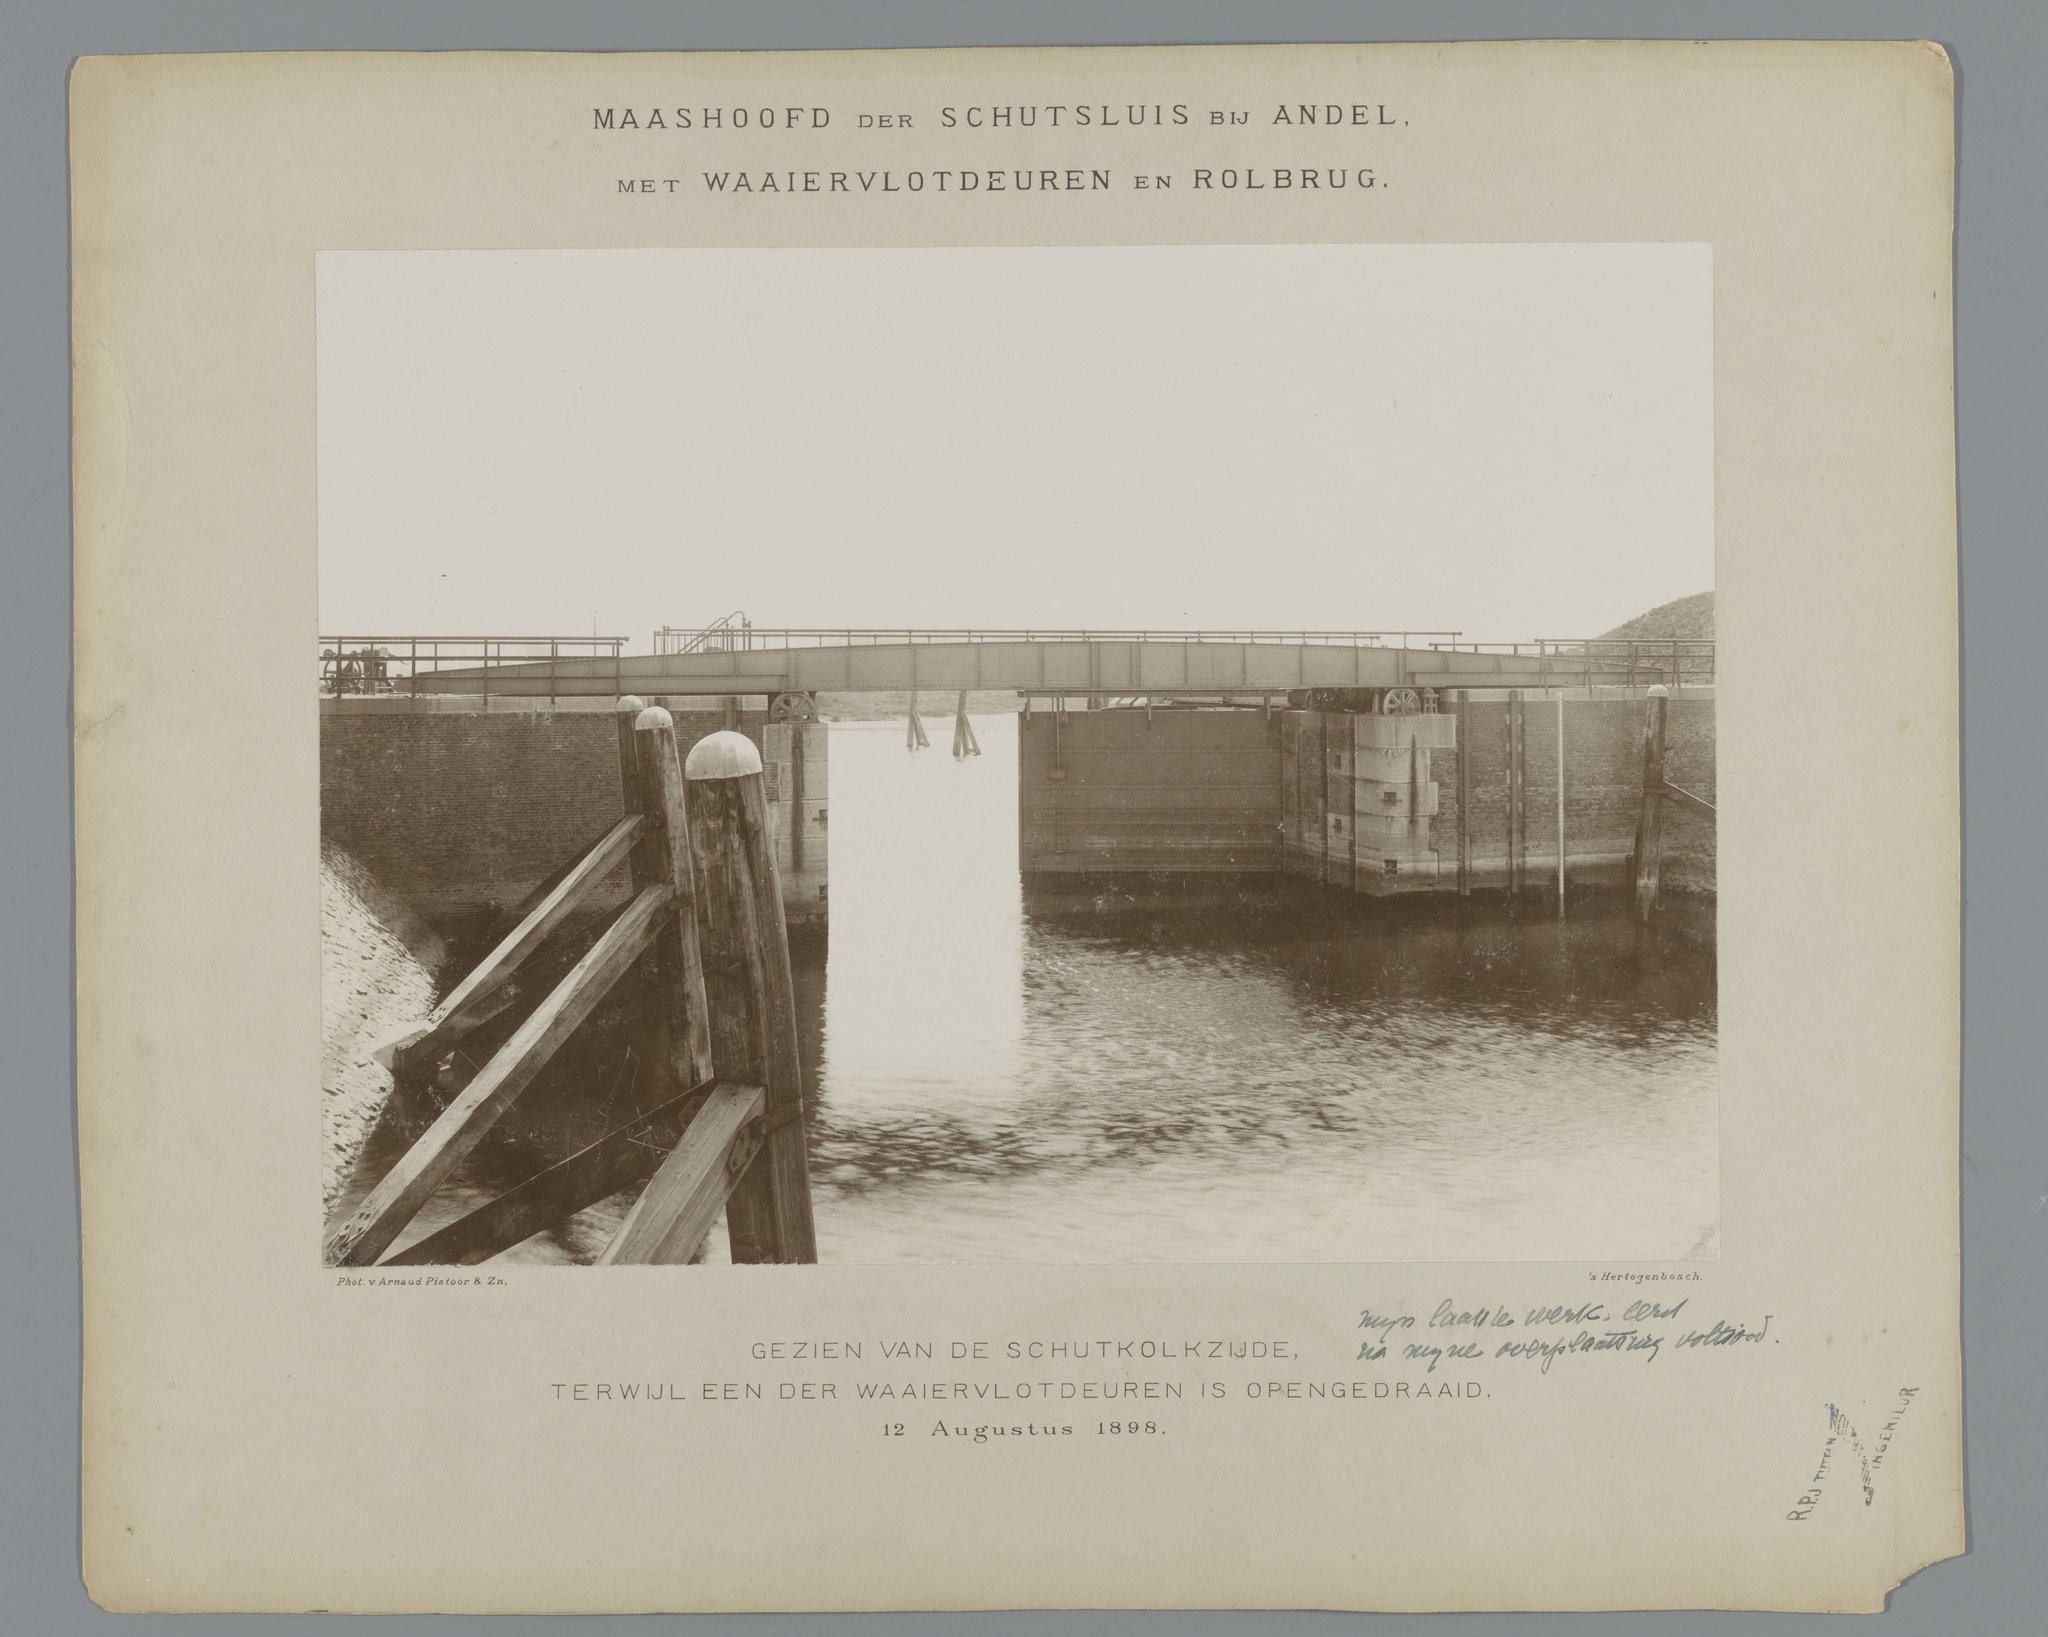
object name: photograph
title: Bouw van de schutsluis bij Andel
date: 1898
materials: cardboard, photographic support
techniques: collodion silver print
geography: andel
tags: sluice, weir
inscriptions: stamp: ‘R.P. TUTEIN // NOLTHENIUS // INGENIEUR’, inscription: ‘MAASHOOFD DER SCHUTSLUIS BIJ ANDEL MET WAAIERVLOTDEUREN EN ROLBRUG // GEZIEN VAN DE SCHUTKOLKZIJDE, TERWIJL EEN DER WAAIERVLOTDEUREN IS OPENGEDRAAID’